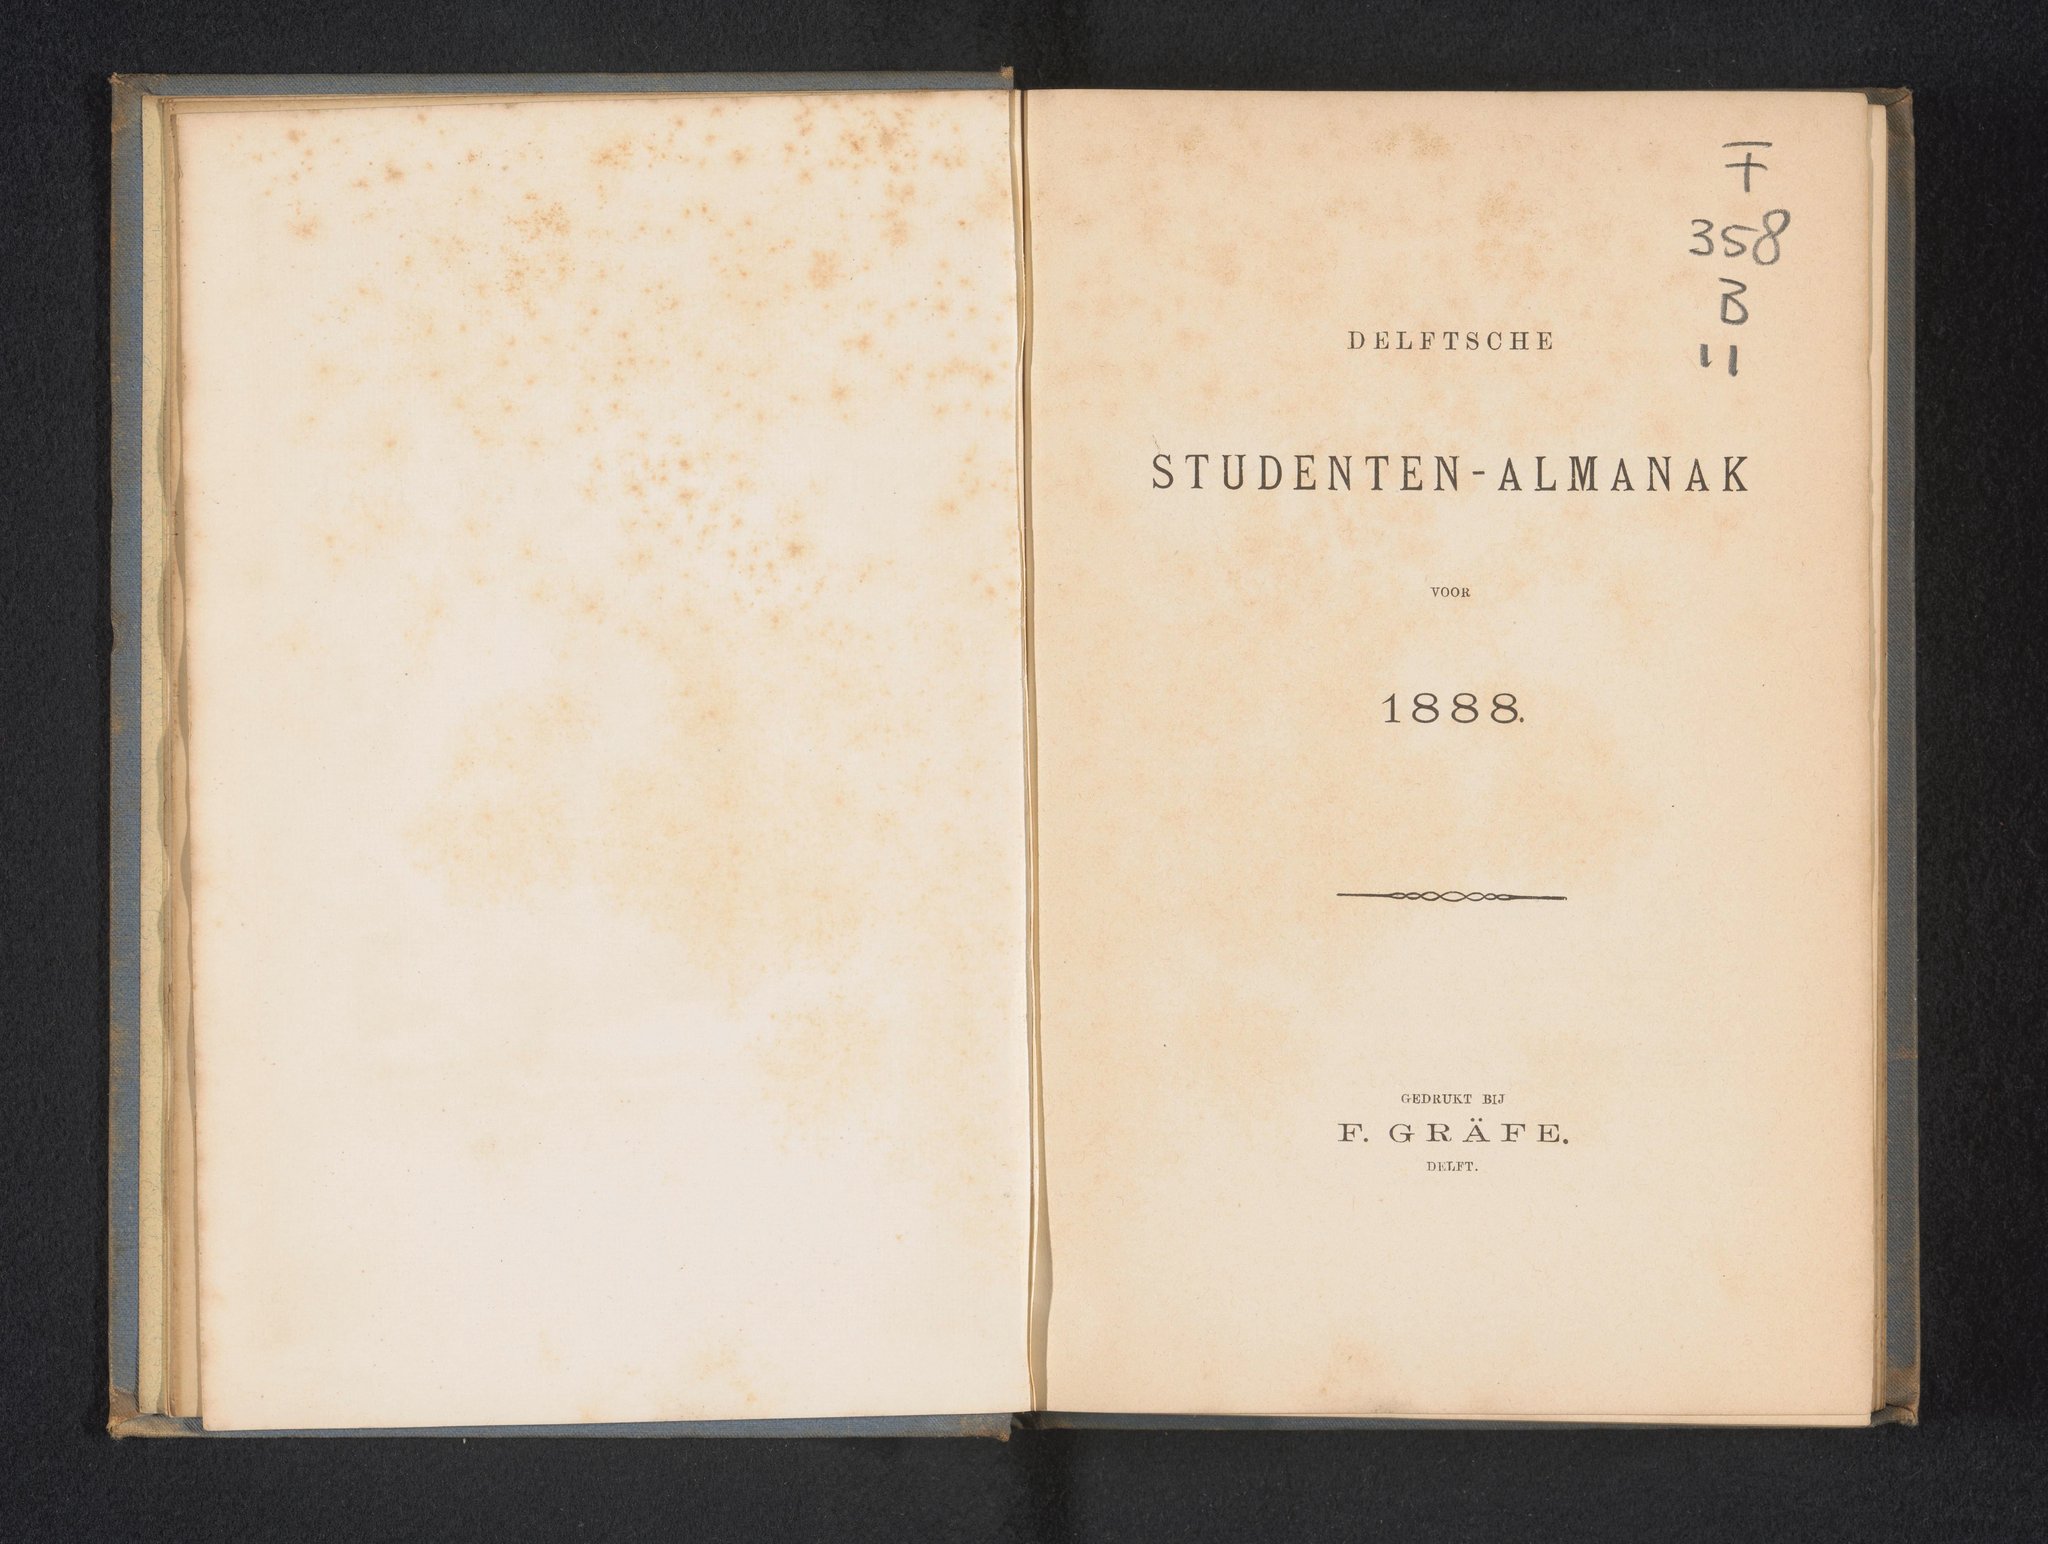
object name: book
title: Delftsche studenten-almanak voor 1888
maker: frederik christiaan filip gräfe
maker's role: fotograaf, lithograaf, steendrukker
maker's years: 1835-1905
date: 1888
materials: cardboard, linen, paper, photographic support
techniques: albumen print, printing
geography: delft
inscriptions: annotation: ‘MAR/ 1993’, number: ‘35,-’